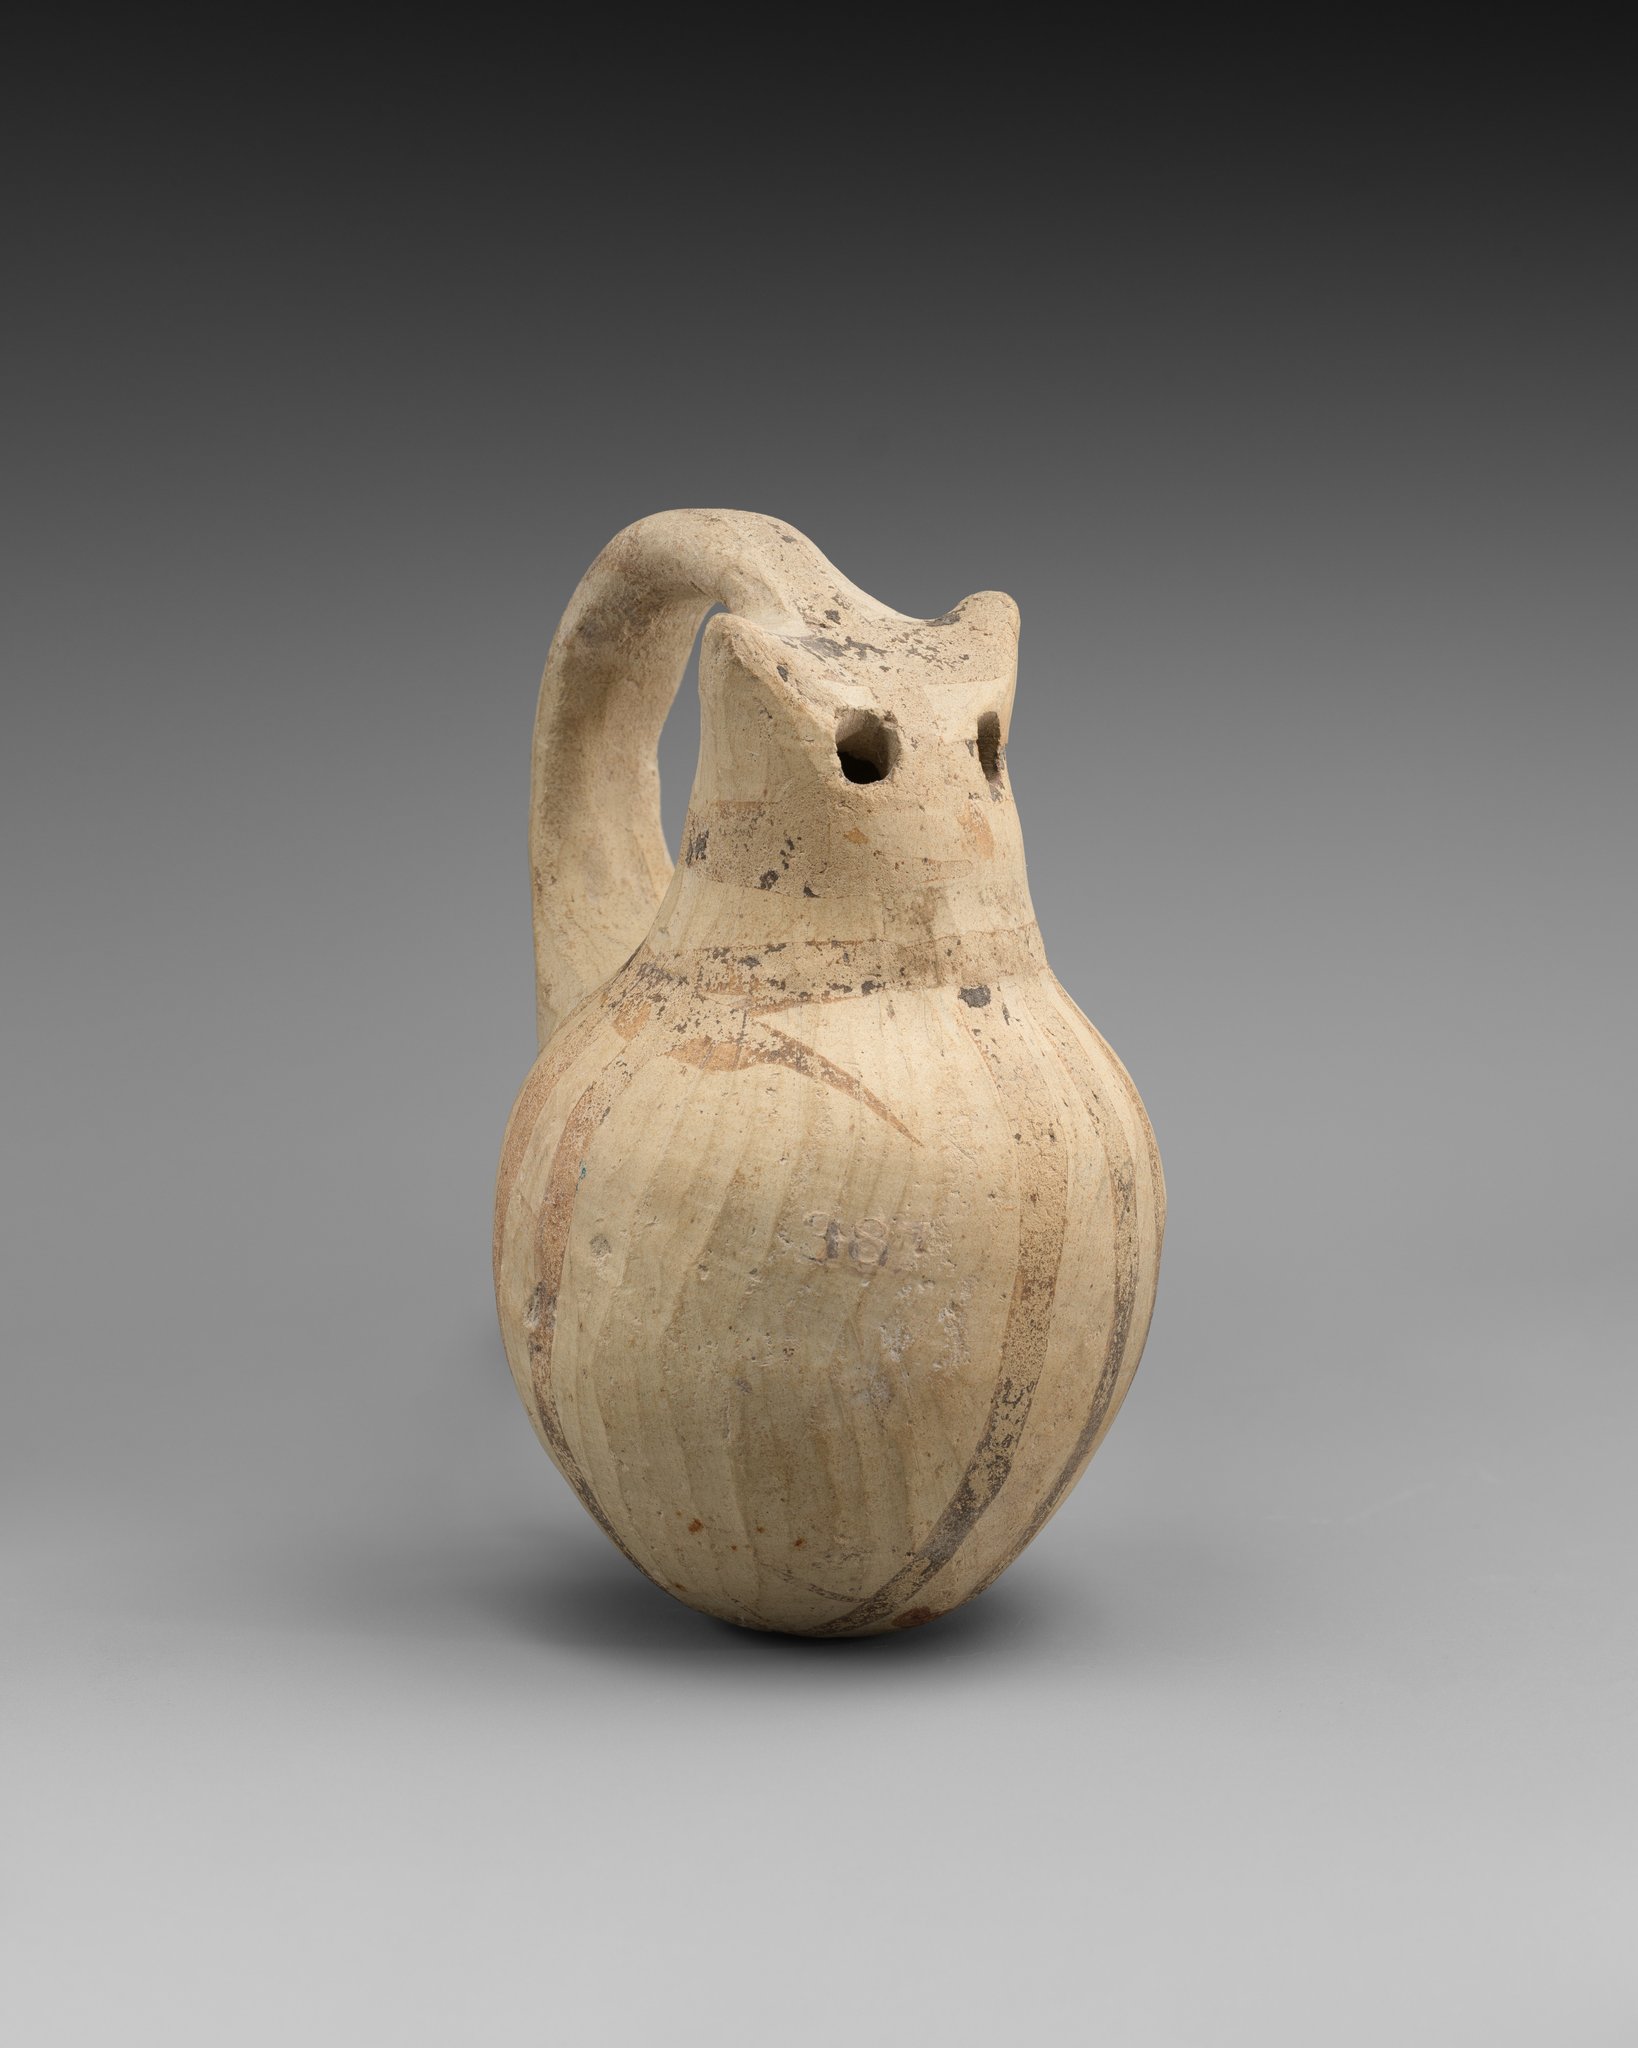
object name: rattle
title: Terracotta rattle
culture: cypriot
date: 1600-1450 BCE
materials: terracotta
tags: birds